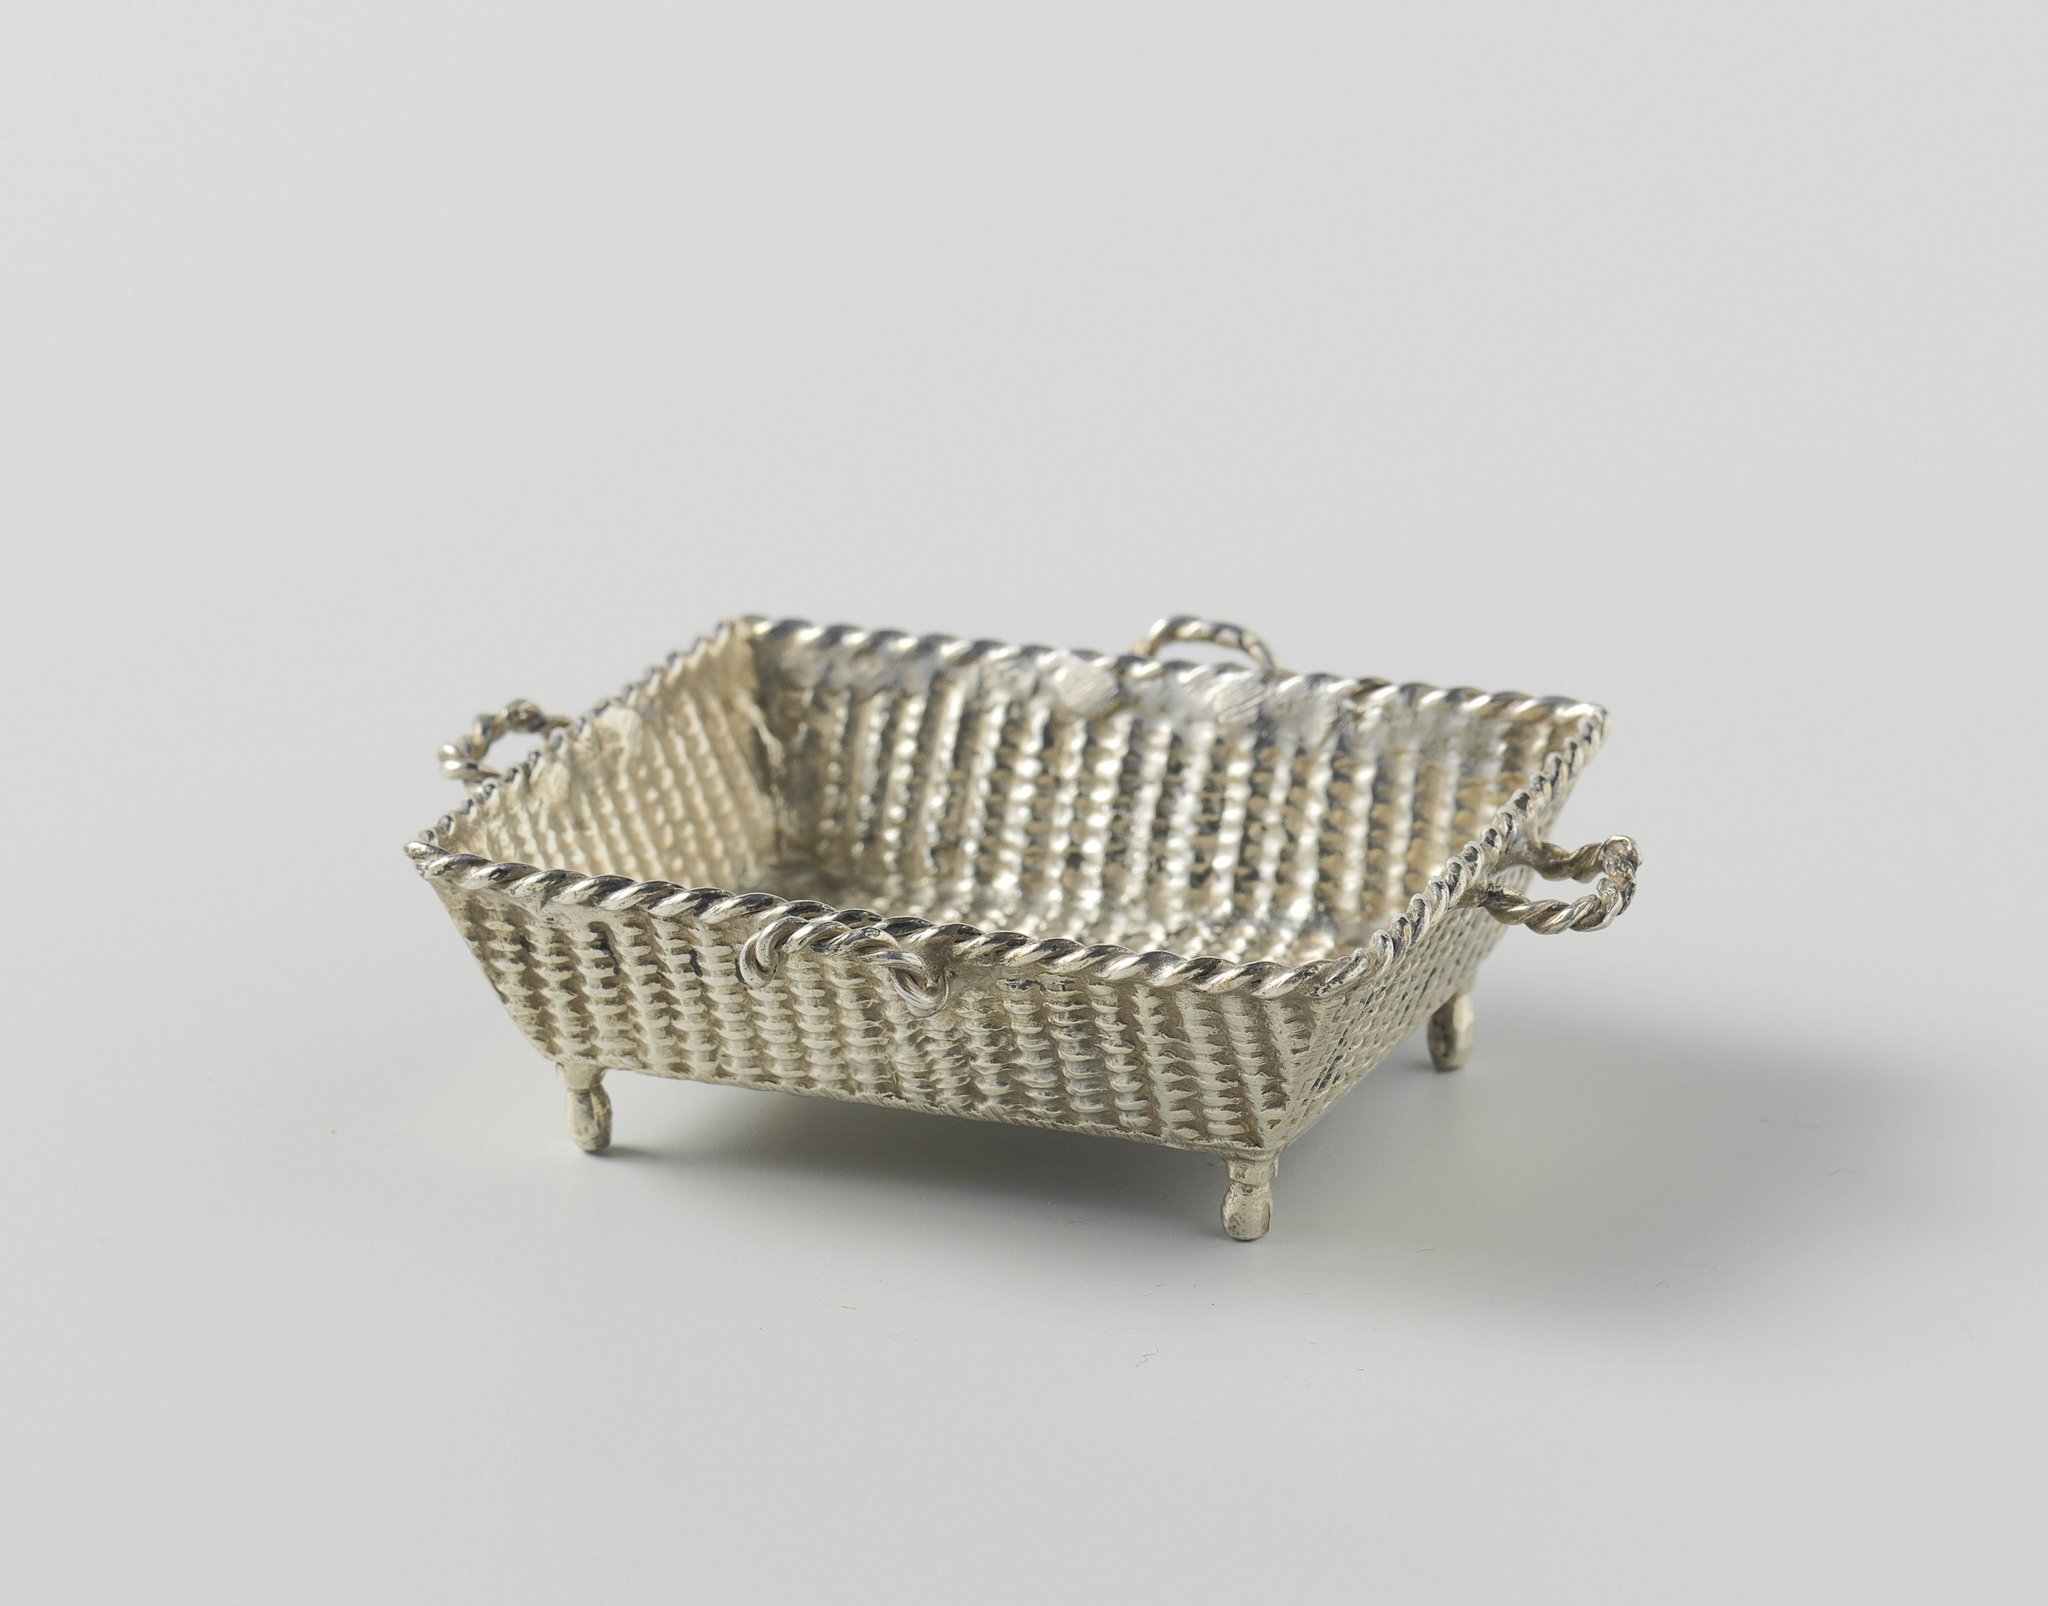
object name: miniature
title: Luiermand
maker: Anonymous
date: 1700-1725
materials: silver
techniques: filigree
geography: amsterdam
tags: furniture for babies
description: Rechthoekige luiermand op vier poten en met vier handvatten. De mand is bewerkt met nagebootst vlechtwerk en is gemerkt: stk.= Amsterdam en een onleesbaar teken.